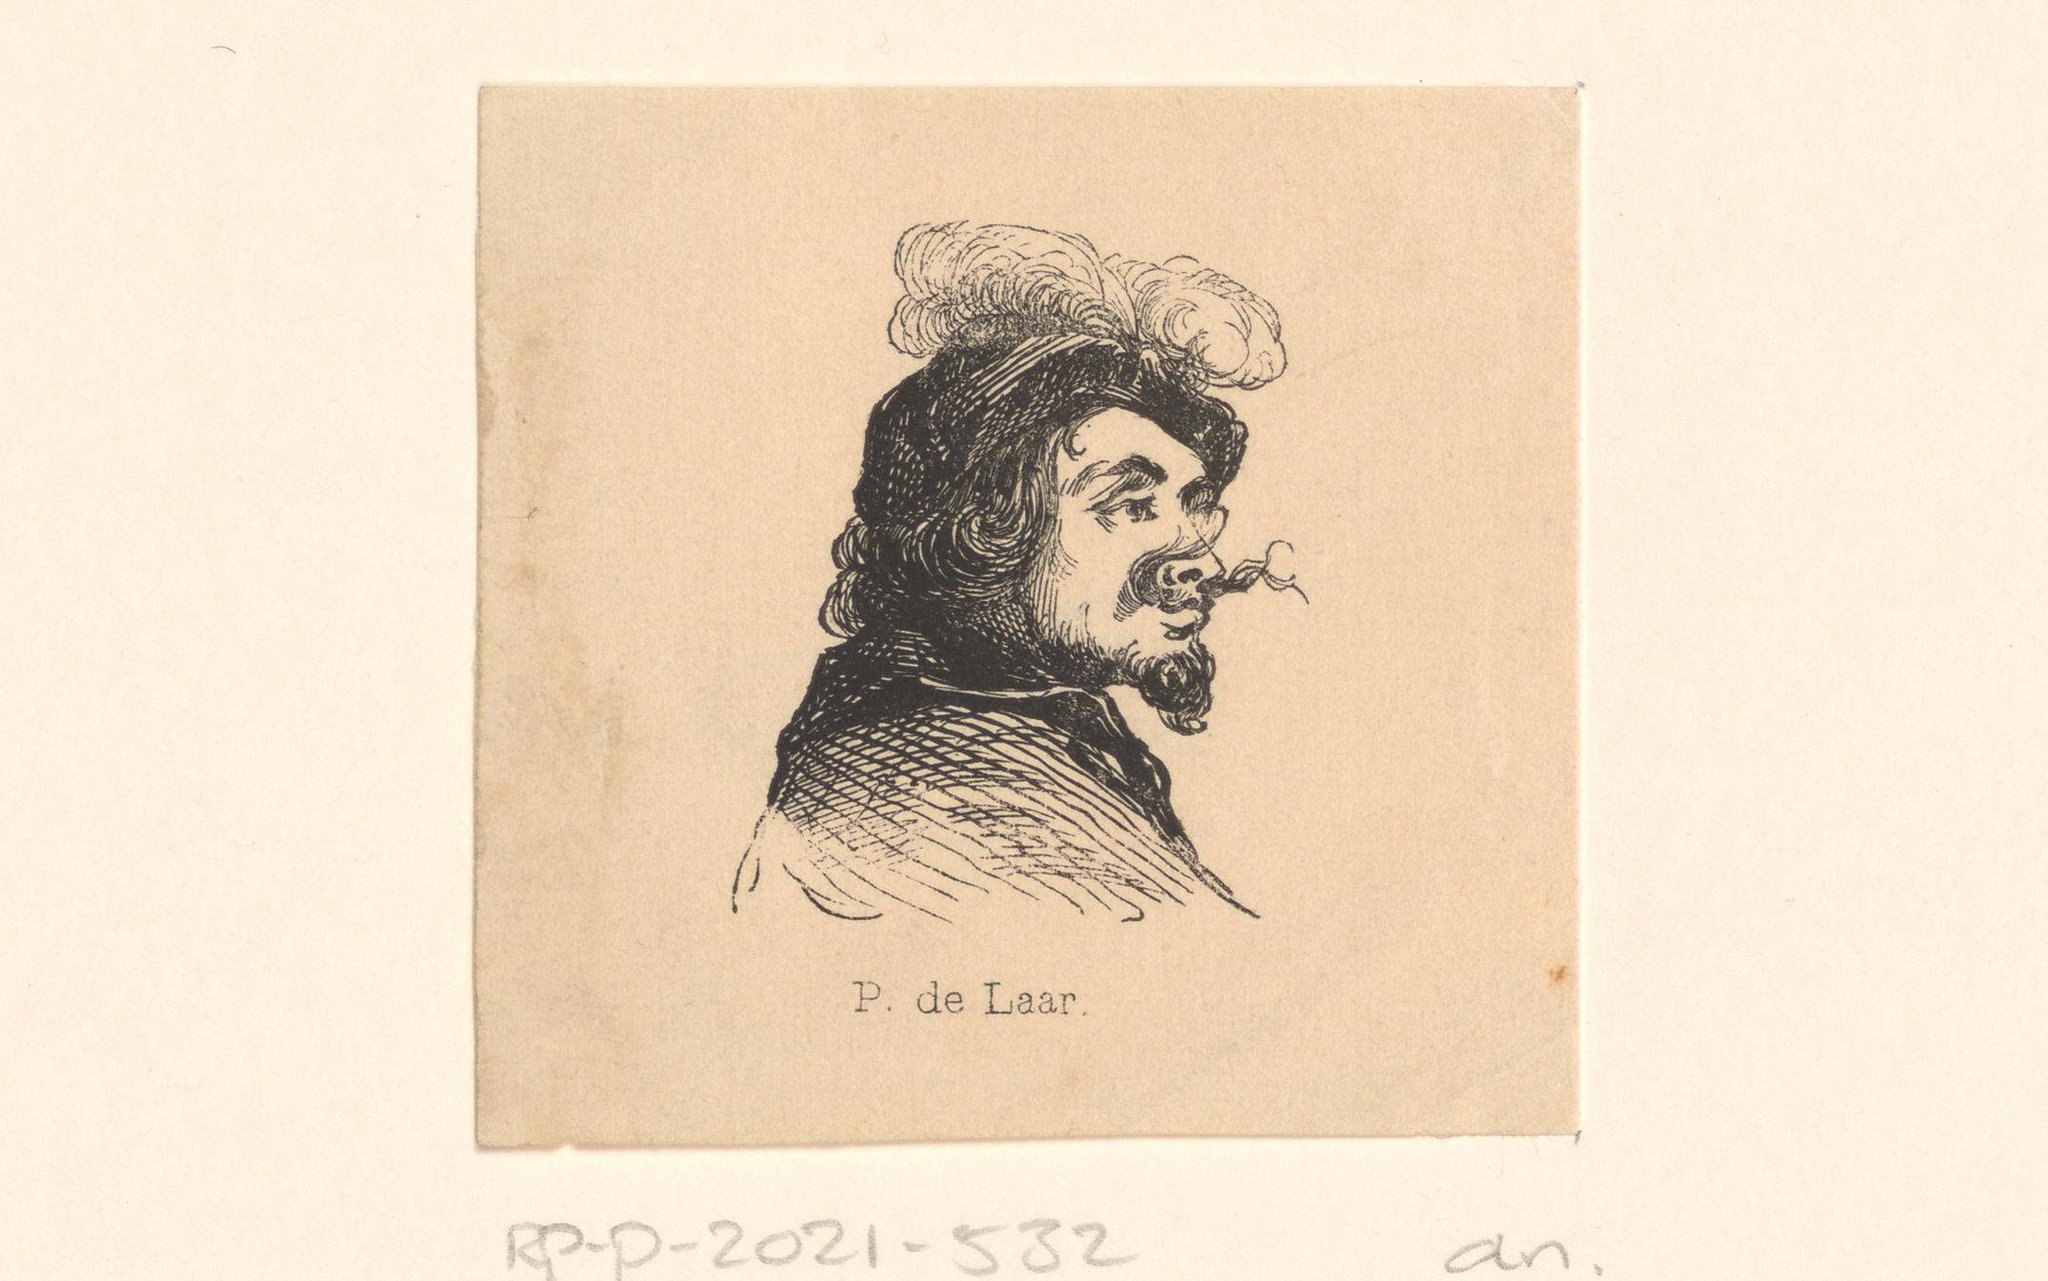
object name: print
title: Portret van Pieter Bodding van Laer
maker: Anonymous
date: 1843-1855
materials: paper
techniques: engraving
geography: netherlands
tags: haarlem, rome, painter, print maker, draughtsman, pieter bodding van laer, historical persons, portrait, self-portrait of painter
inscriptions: collector's mark: Lugt 964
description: Prent met tekst in boekdruk op verso gebruikt in: Immerzeel, Johannes. De levens en werken der Hollandsche en Vlaamsche kunstschilders (...). Amsterdam: C.H. Immerzeel en C. Immerzeel, 1843, dl. 2, p. 145. De prent is ook met tekst in boekdruk op verso gebruikt in de editie uit 1855.